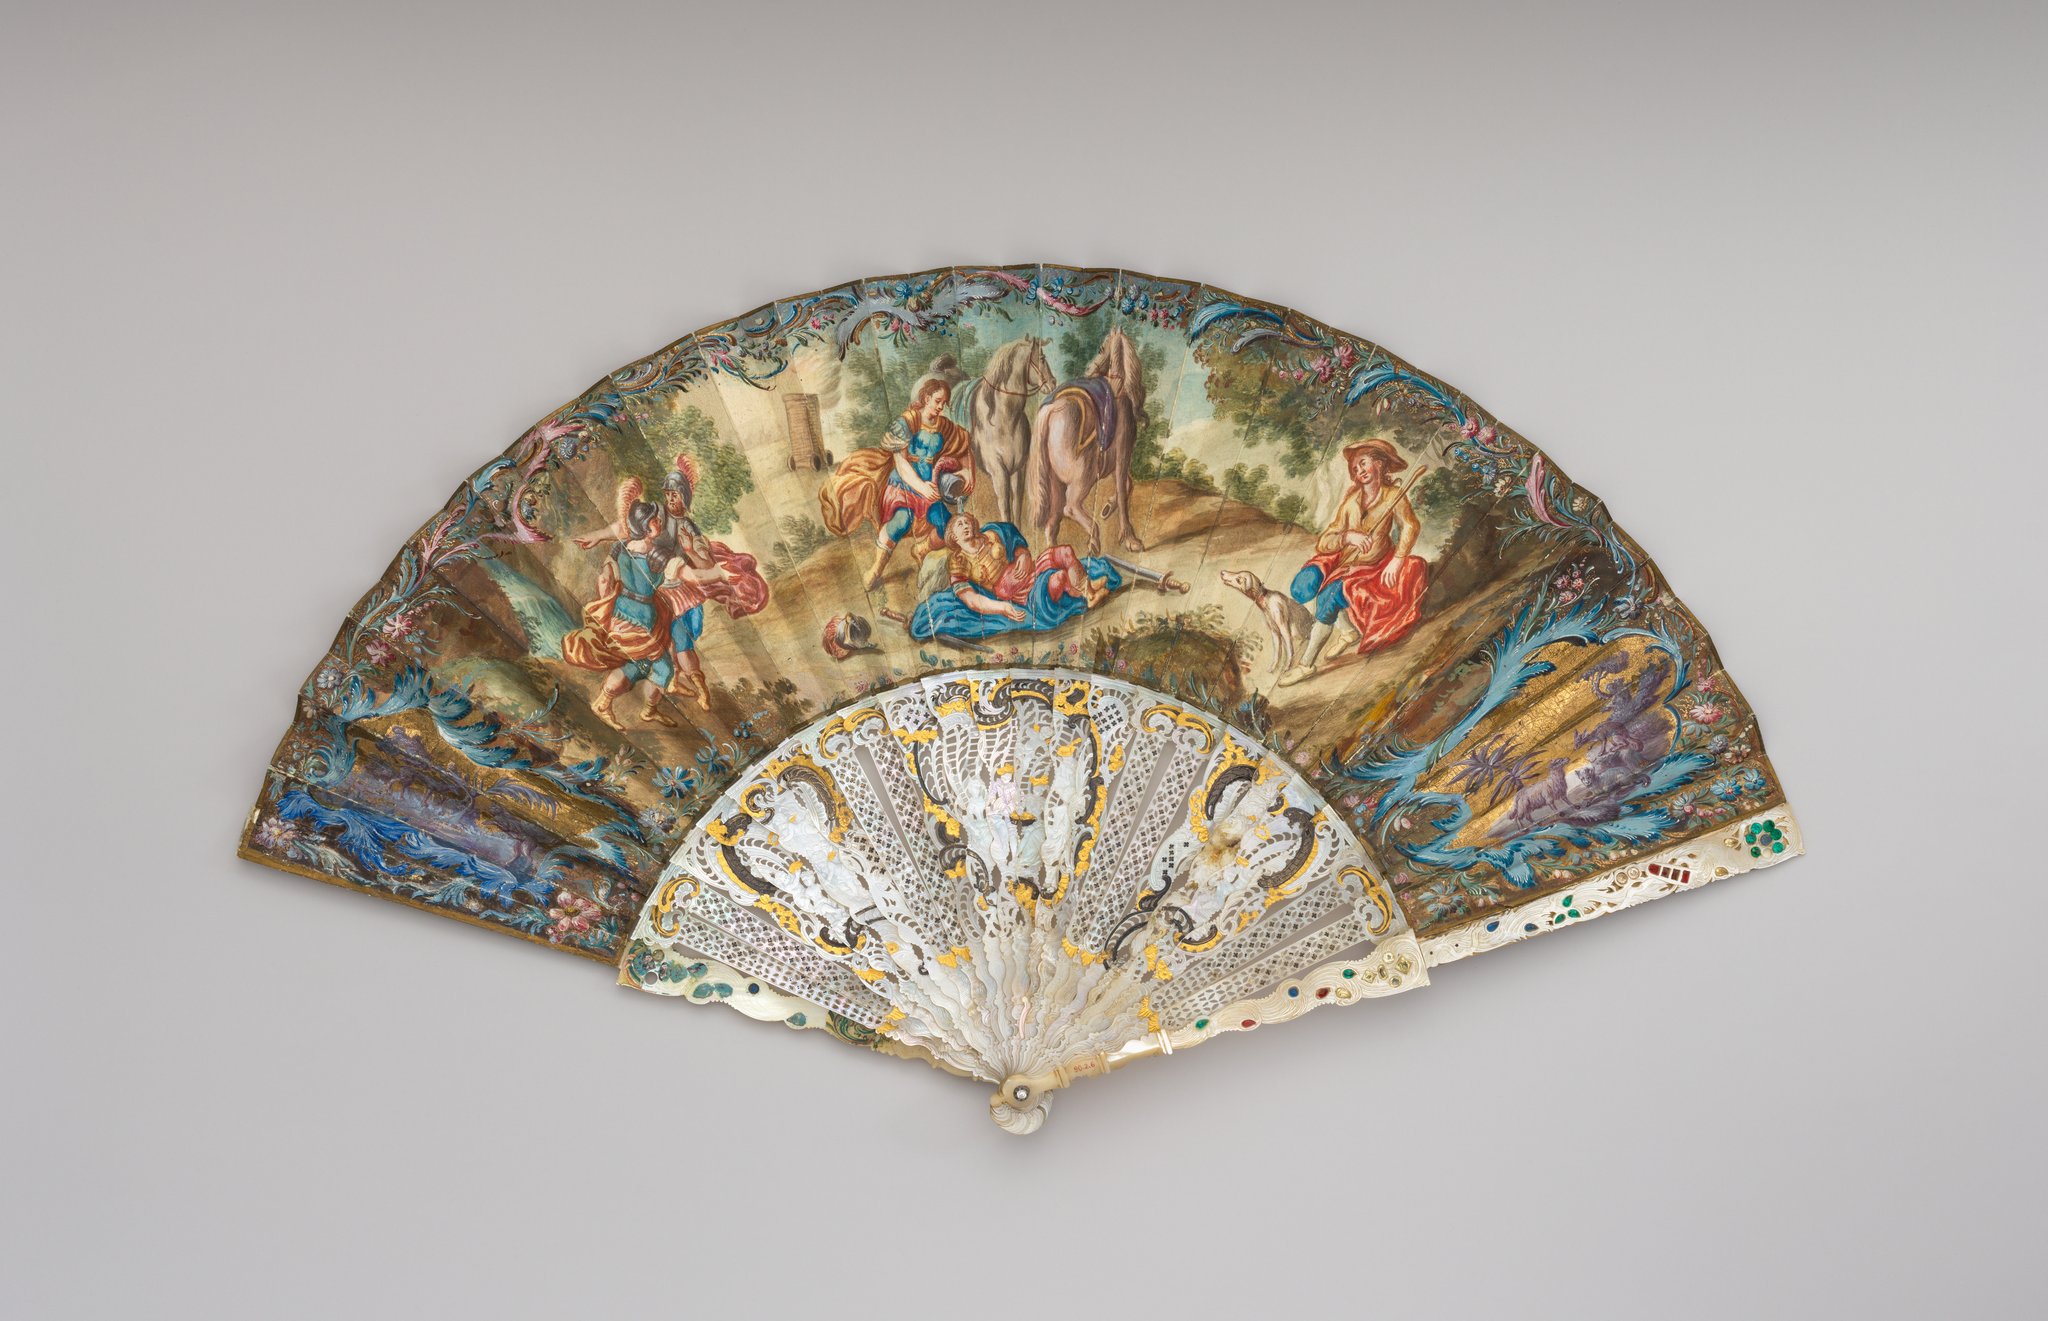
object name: fan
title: Tancred and Clorinda, from the story "Gerusalemme Liberata"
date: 1734-1766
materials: gold, mother of pearl, paint, parchment, stone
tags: soldiers,dogs,horses